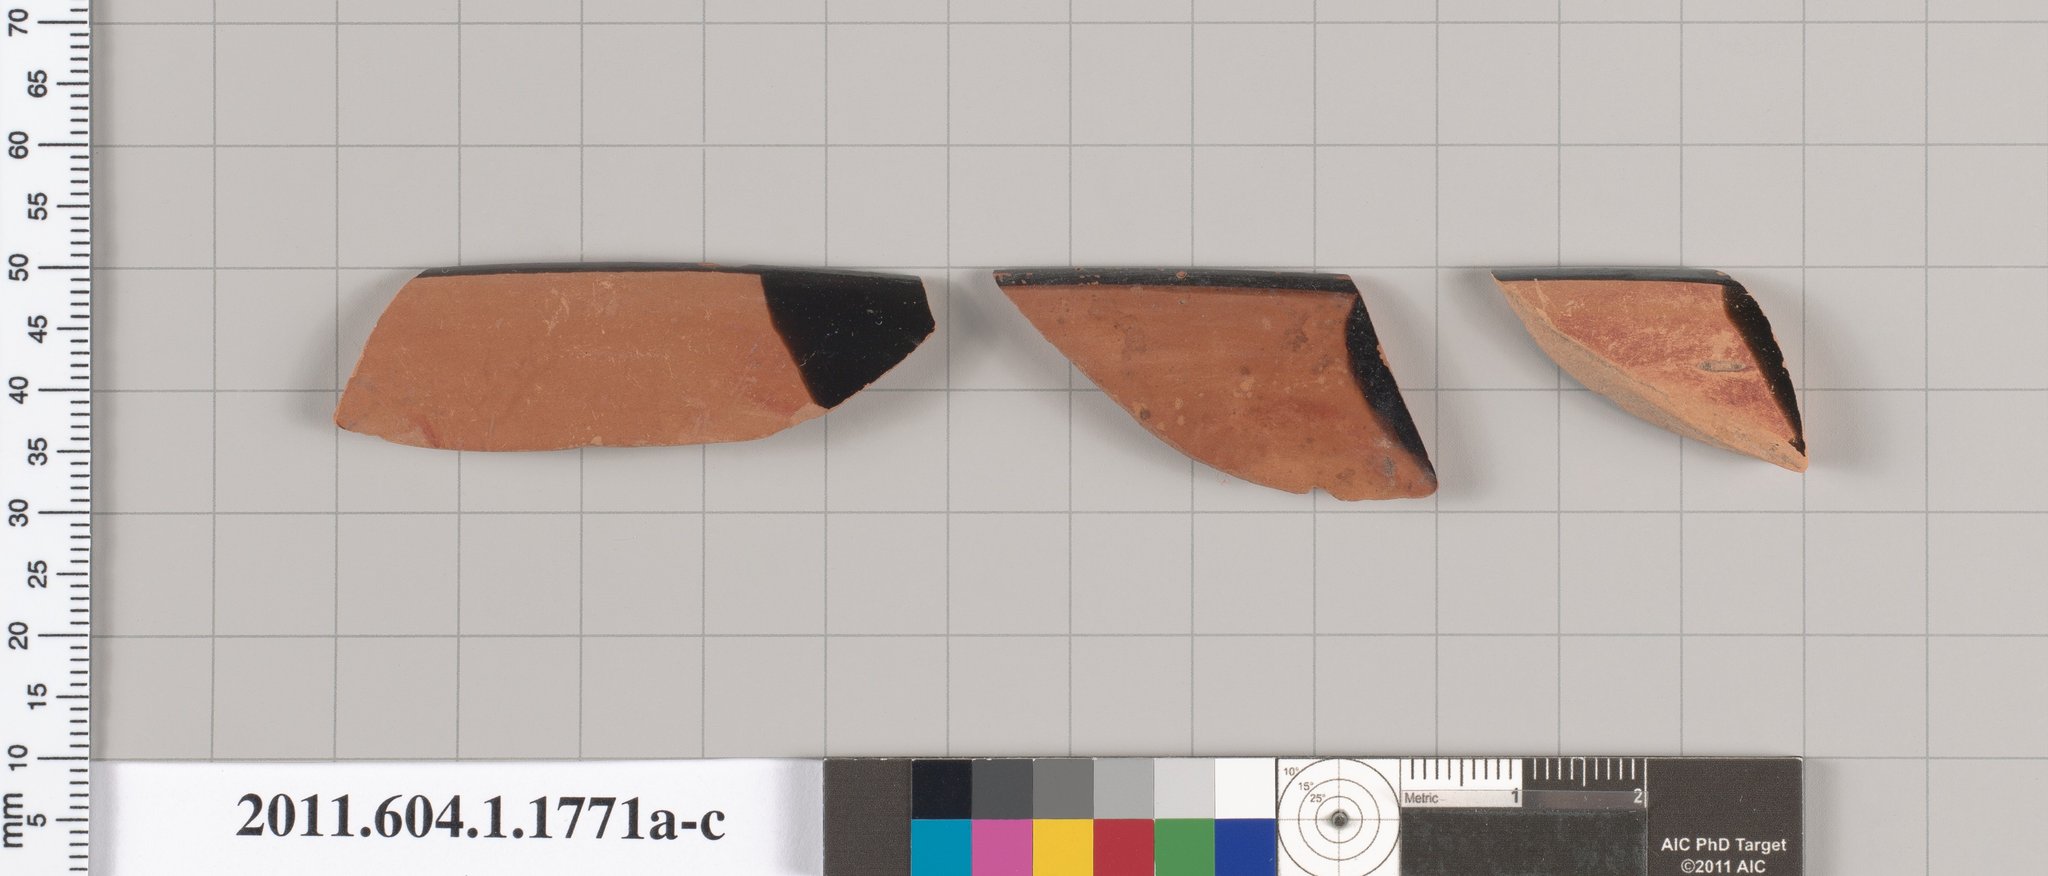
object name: kylix fragment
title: Terracotta rim fragments of kylikes(drinking cups)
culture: greek, attic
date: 500-401 BCE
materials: terracotta